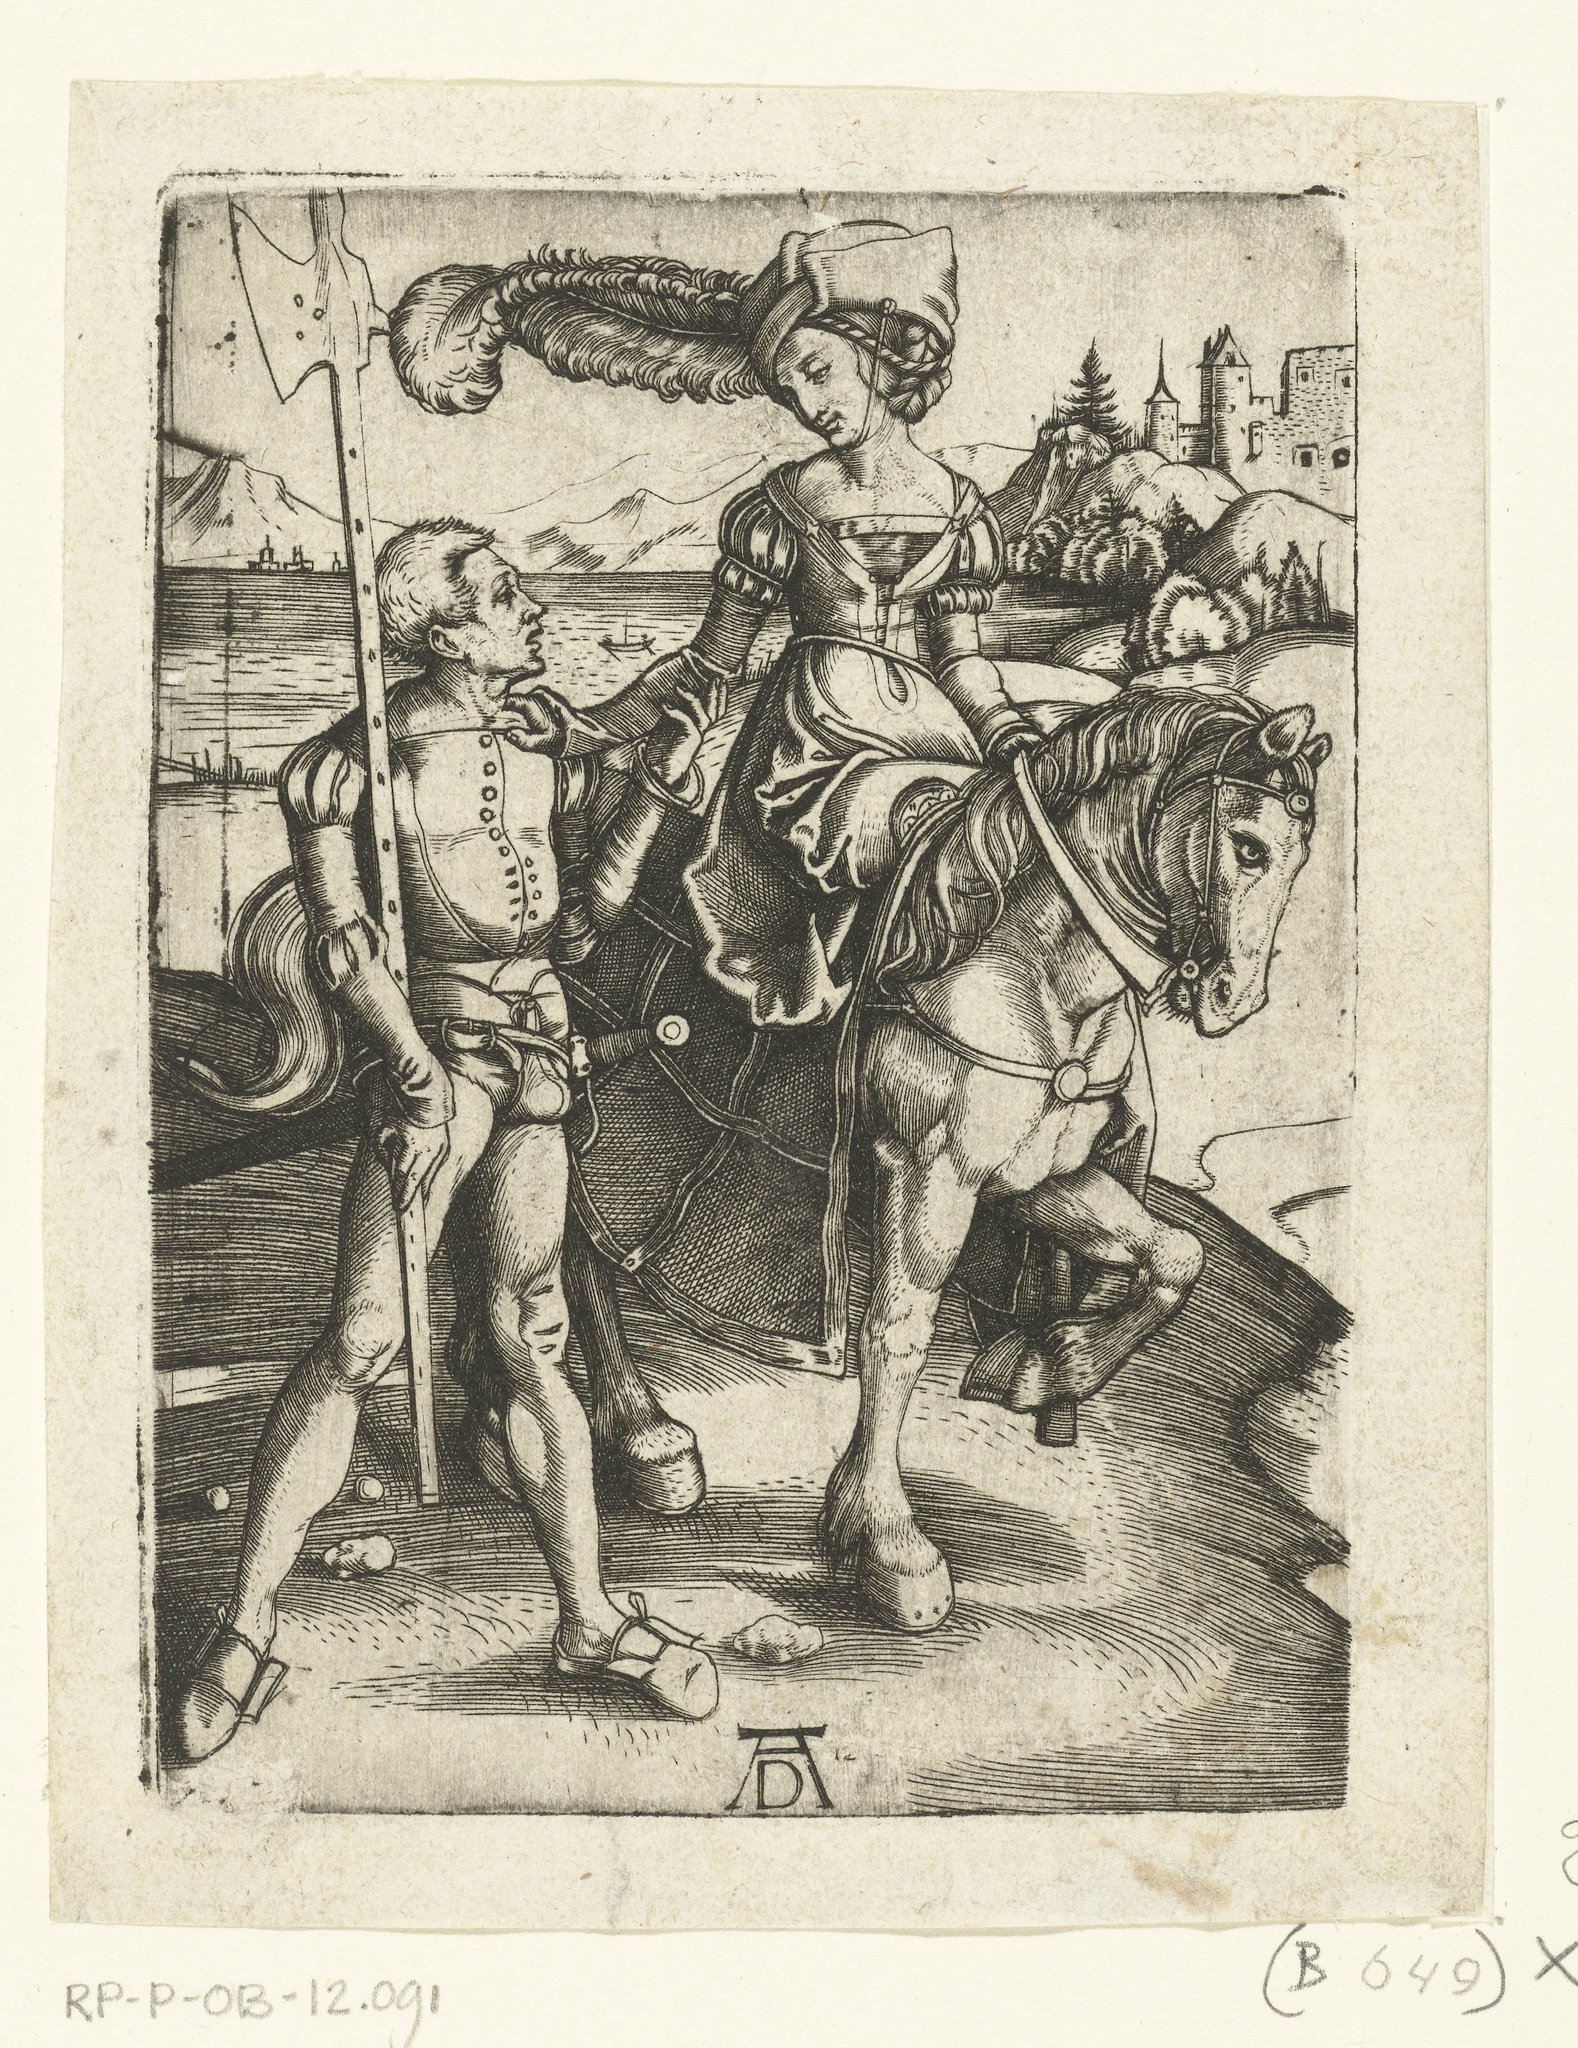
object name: print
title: Vrouw te paard en man met hellebaard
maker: albrecht dürer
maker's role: draughtsman, painter, print maker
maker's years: 1471-1528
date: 1549-1624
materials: paper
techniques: engraving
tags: riding a horse, ass, or mule; rider, horseman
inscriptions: collector's mark: Lugt 12